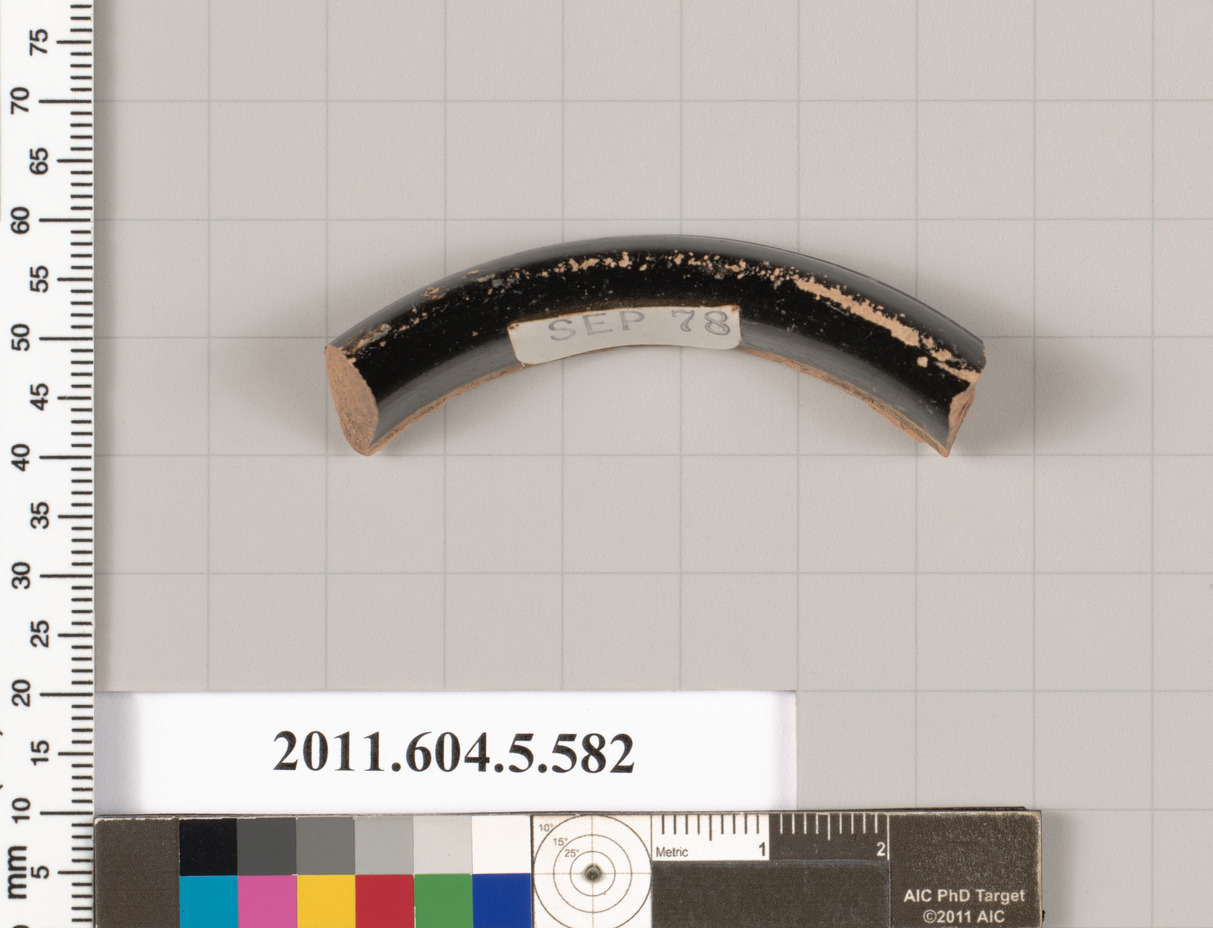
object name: stemless kylix fragment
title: Terracotta fragment of a stemless kylix (drinking cup)?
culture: greek, attic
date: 600-401 BCE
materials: terracotta